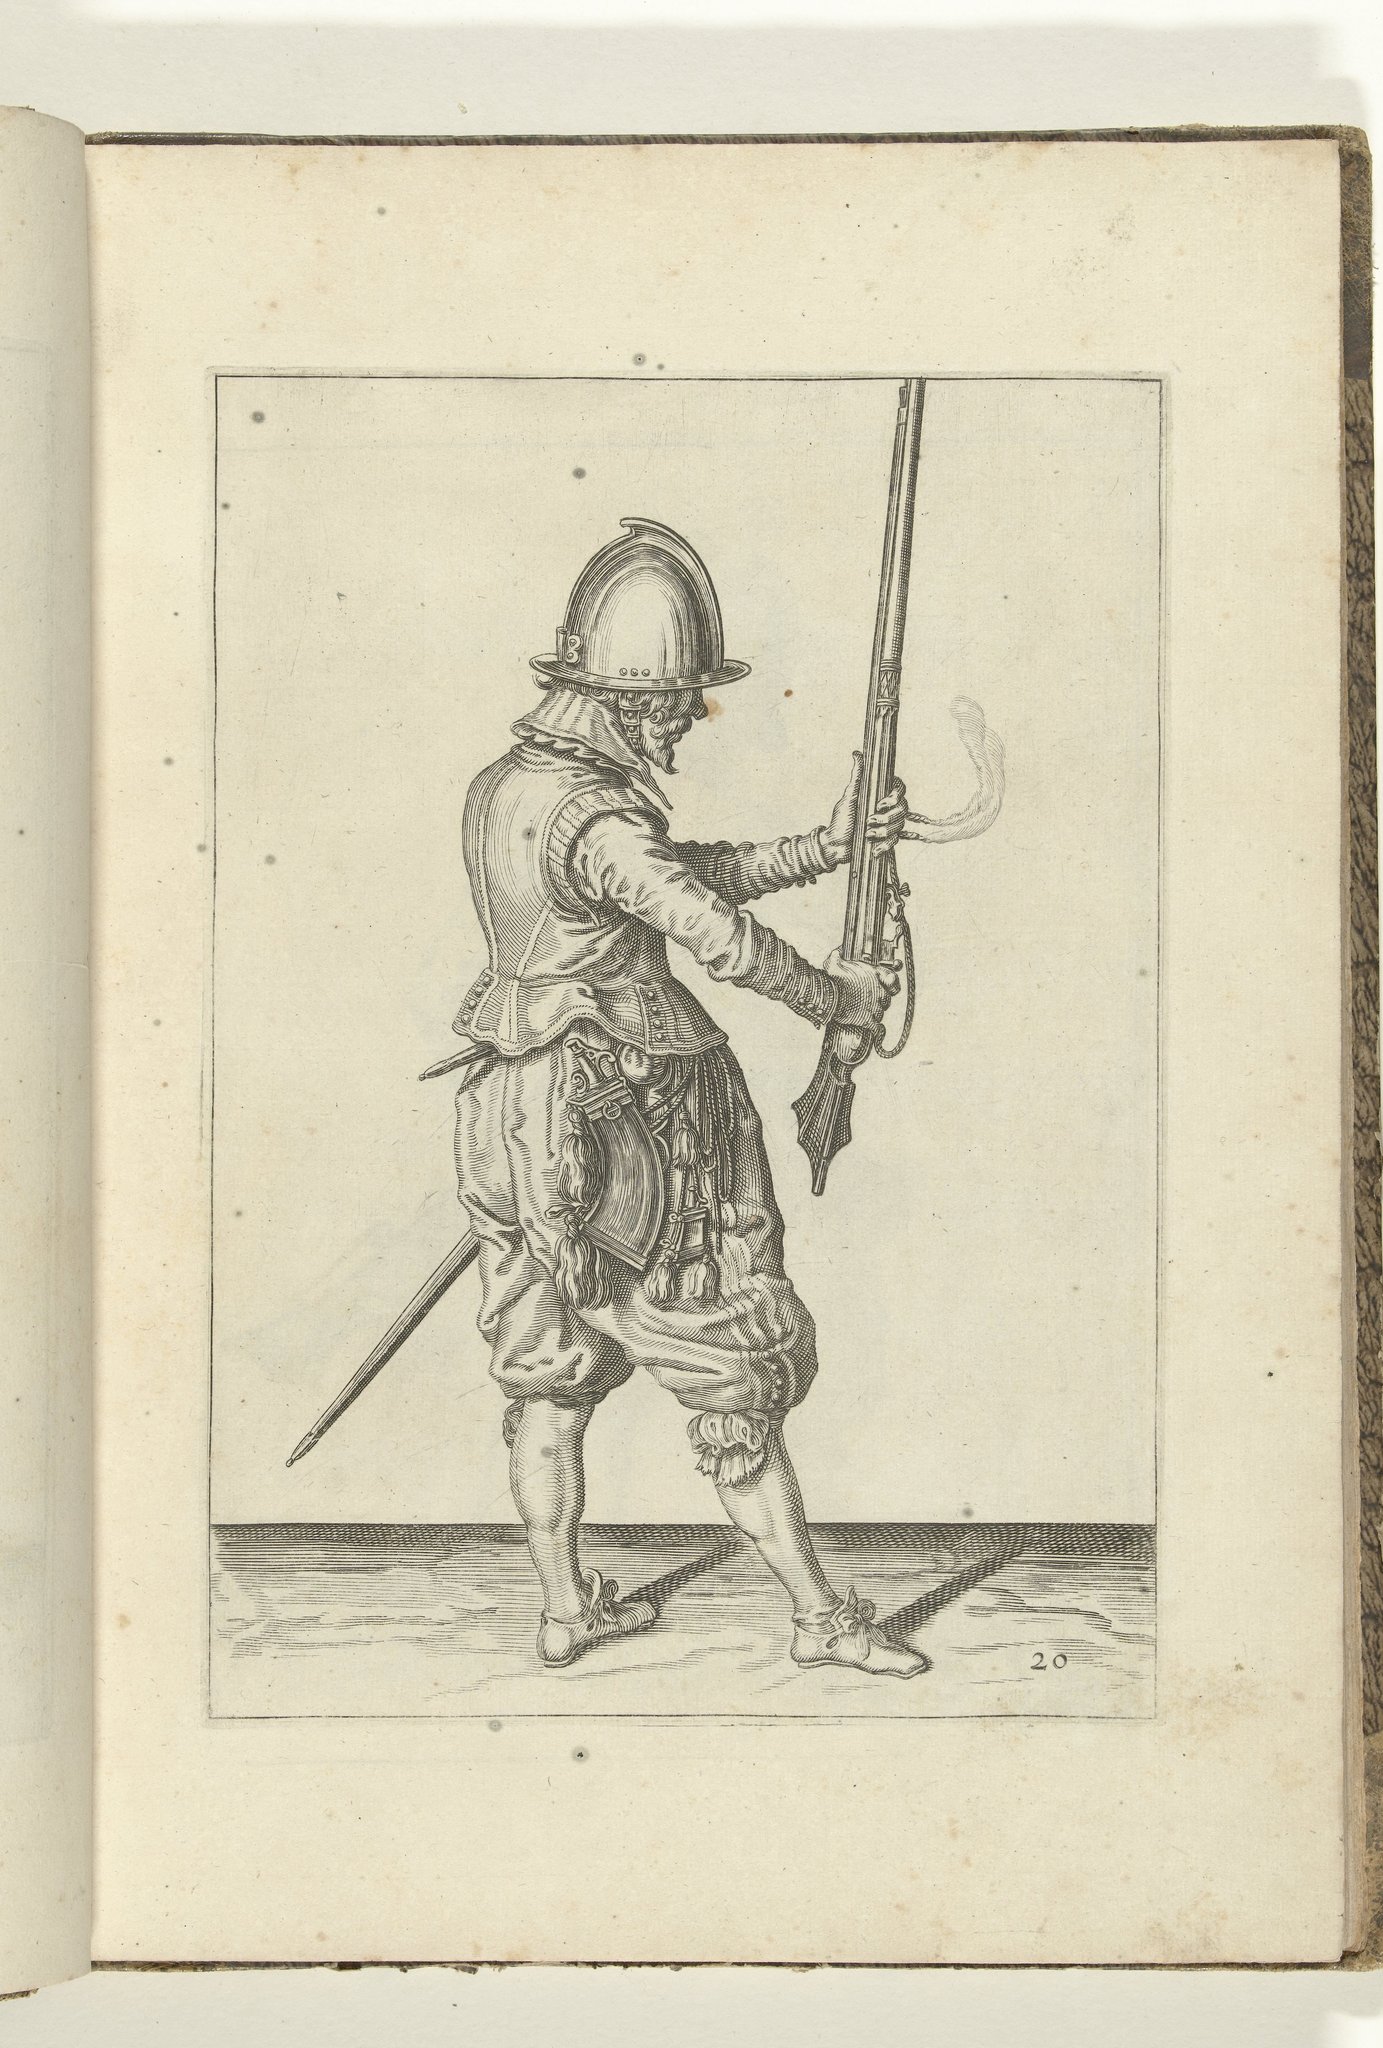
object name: print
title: Soldaat die zijn roer met beide handen rechtop voor zich vasthoudt (nr. 20), ca. 1600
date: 1597-1608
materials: paper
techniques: engraving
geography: northern netherlands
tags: maurice (prince of orange), handling of weapons ~ military training, weapons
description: Een soldaat, ten voeten uit, naar rechts, die een roer (een bepaald type vuurwapen) met beide handen voor zich vasthoudt, de loop omhoog wijzend, om het naar zijn linkerzijde te brengen (nr. 20), ca. 1600. In zijn linkerhand behalve de loop van het roer ook een brandende lont. Plaat 20 in de instructies voor het hanteren van de roer: Corte onderwysinghe op de figuerliicke afbeeldinghe, belanghende t'rechte ghebruyck des Roers. Onderdeel van de illustraties in: J. de Gheyn, Wapenhandelinghe van Roers Musquetten ende spiessen, 's-Gravenhage, 1607. Krijgswezen rond 1600.